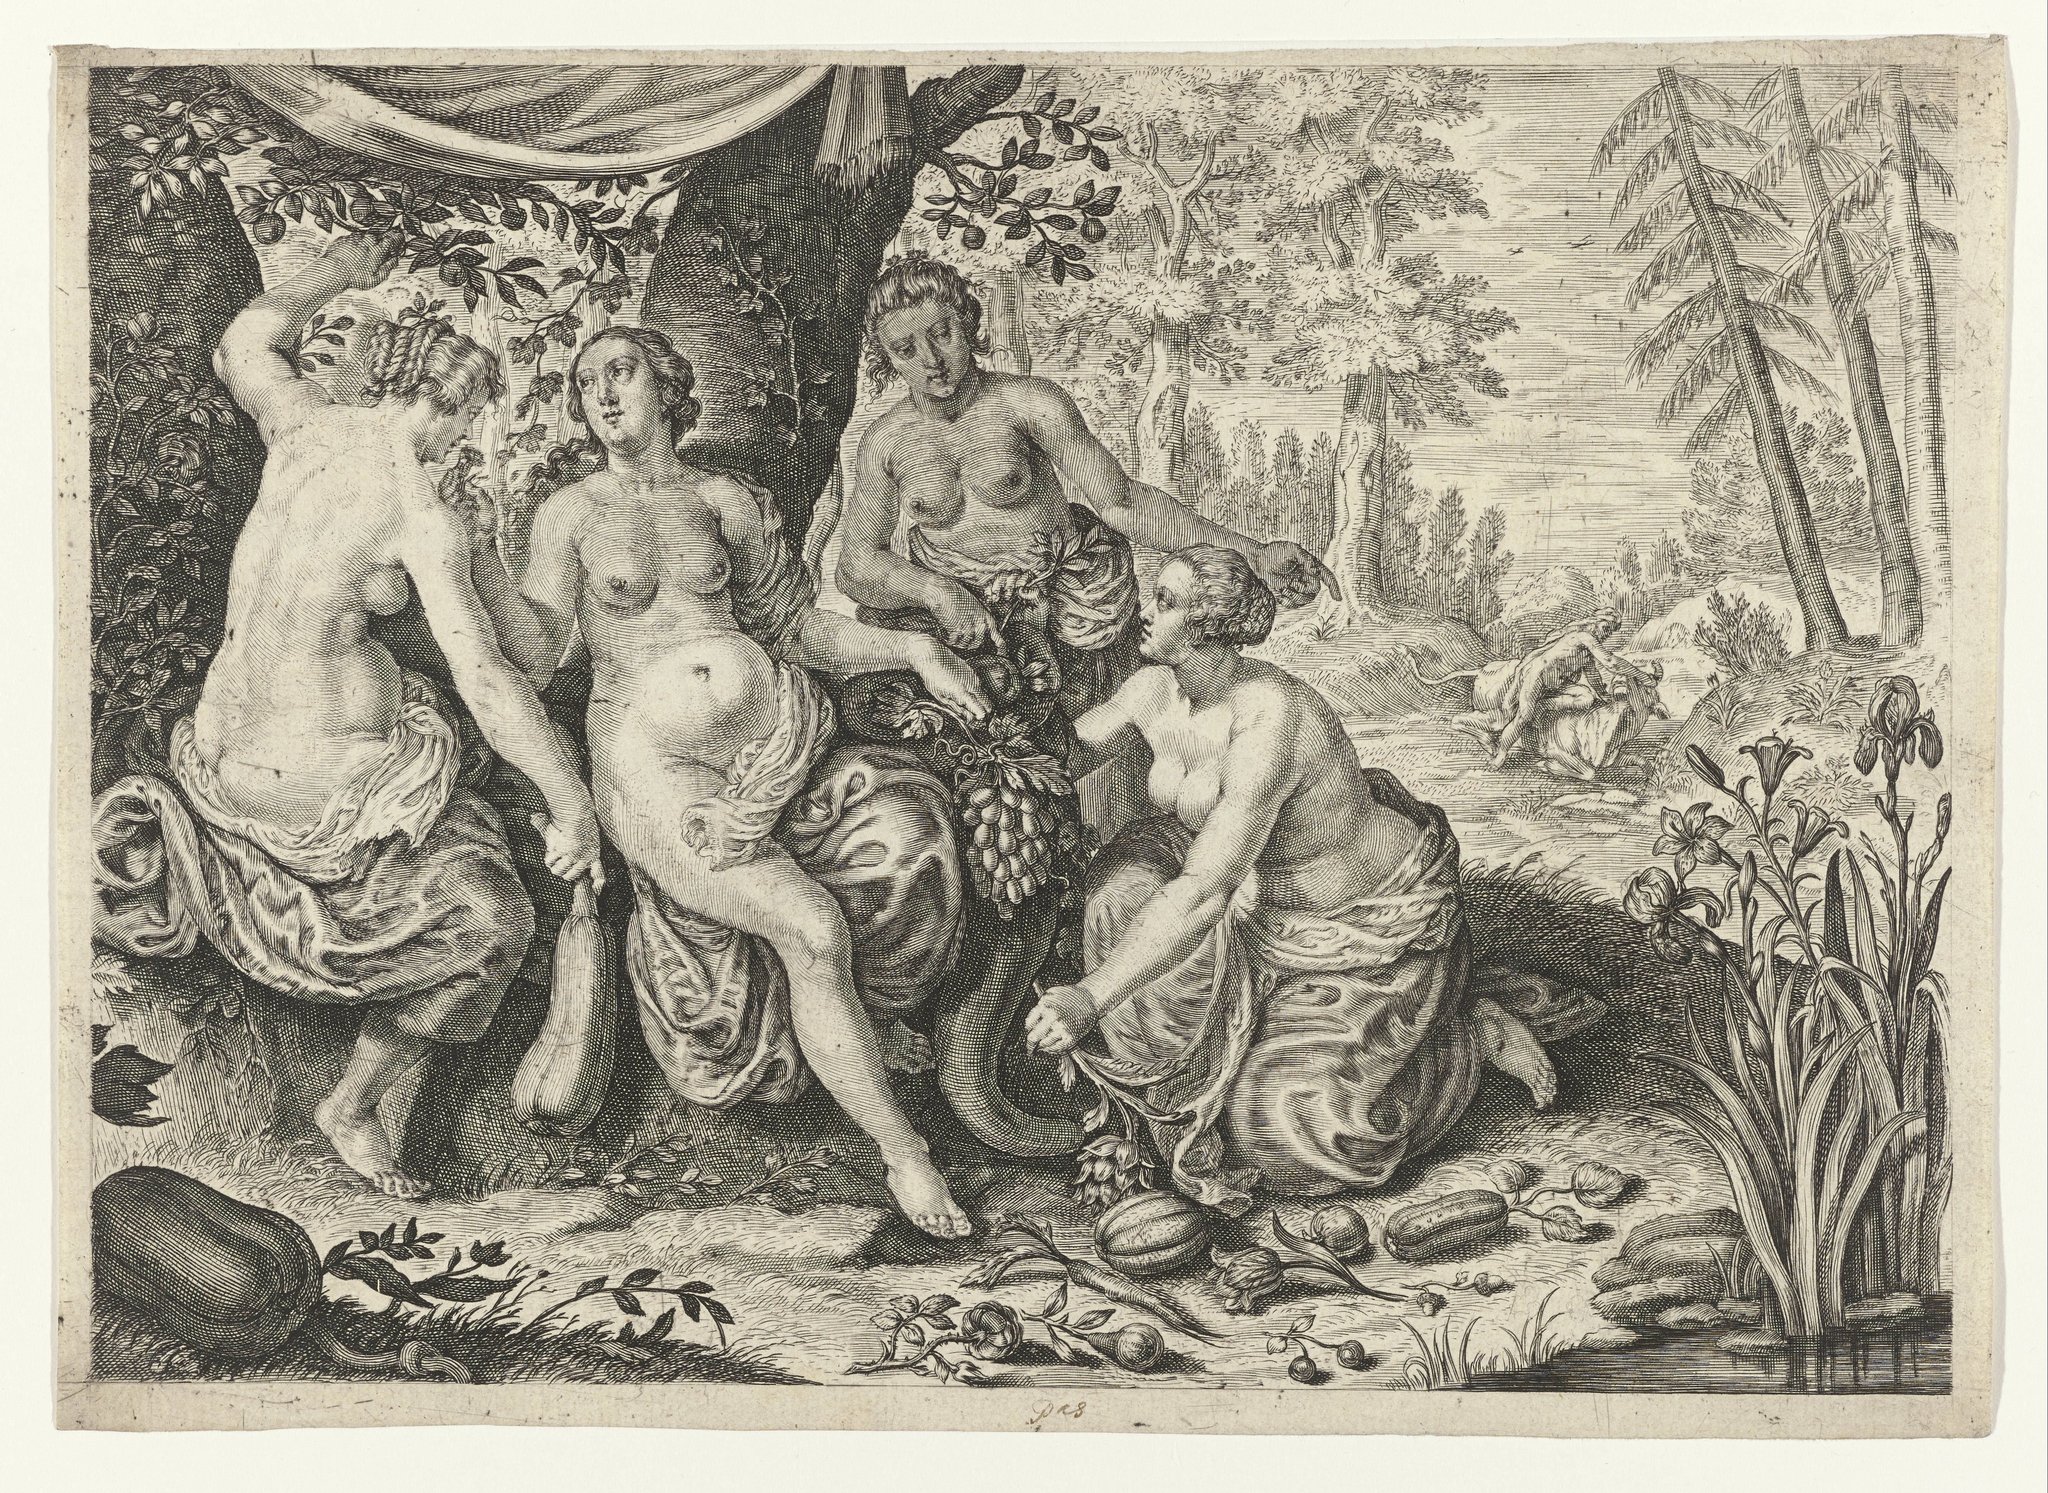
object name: print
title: Nimfen vullen de hoorn des overvloeds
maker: crispijn van de passe (ii)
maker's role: draughtsman, print maker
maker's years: 1594-1670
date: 1636-1670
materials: paper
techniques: engraving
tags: 'cornucopia', horn of plenty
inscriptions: annotation: ‘Pas’, number: ‘56’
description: De ambitieuze reeks naar ontwerpen van ondermeer Jacob Pynas, Roeland Savery, Pieter Clouwet, Rubens en Rembrandt is nooit voltooid door de De Passes. De reeks werd uiteindelijk in 1677 in boekvorm uitgegeven in Brussel door Piere Du Rayer en Francois Foppes. Als losse prenten is de reeks alleen bekend uit een groep prenten afkomstig uit de collectie Hinloopen (1619-1708) die zich in het Rijksprentenkabinet bevindt. Deze groep is uitgebreid beschreven door Jan van der Waals in zijn Hinloopen-catalogus (zie: ''Een onbekende editie van een serie Ovidius-illustraties'' in De prentschat van Michiel Hinloopen, 1988, p. 79-102.). De ontdekking van een tweede groep afdrukken van de reeks, afkomstig uit de werkplaats van Crispijn de Passe de Jonge, biedt een belangrijke aanvulling op de Hinloopen-groep. Sommige afdrukken tonen de prenten in onvoltooide staat en zijn voorzien van verbeteringen en toevoegingen in pen en penseel. Bovendien zijn alle prenten voorzien van 17de-eeuwse opschriften die het in een aantal gevallen mogelijk maakt de ontwerpers van de voorstellingen nader te identificeren. Op grond van de aangetroffen watermerken kunnen de afdrukken worden gedateerd omstreeks 1652-1653.